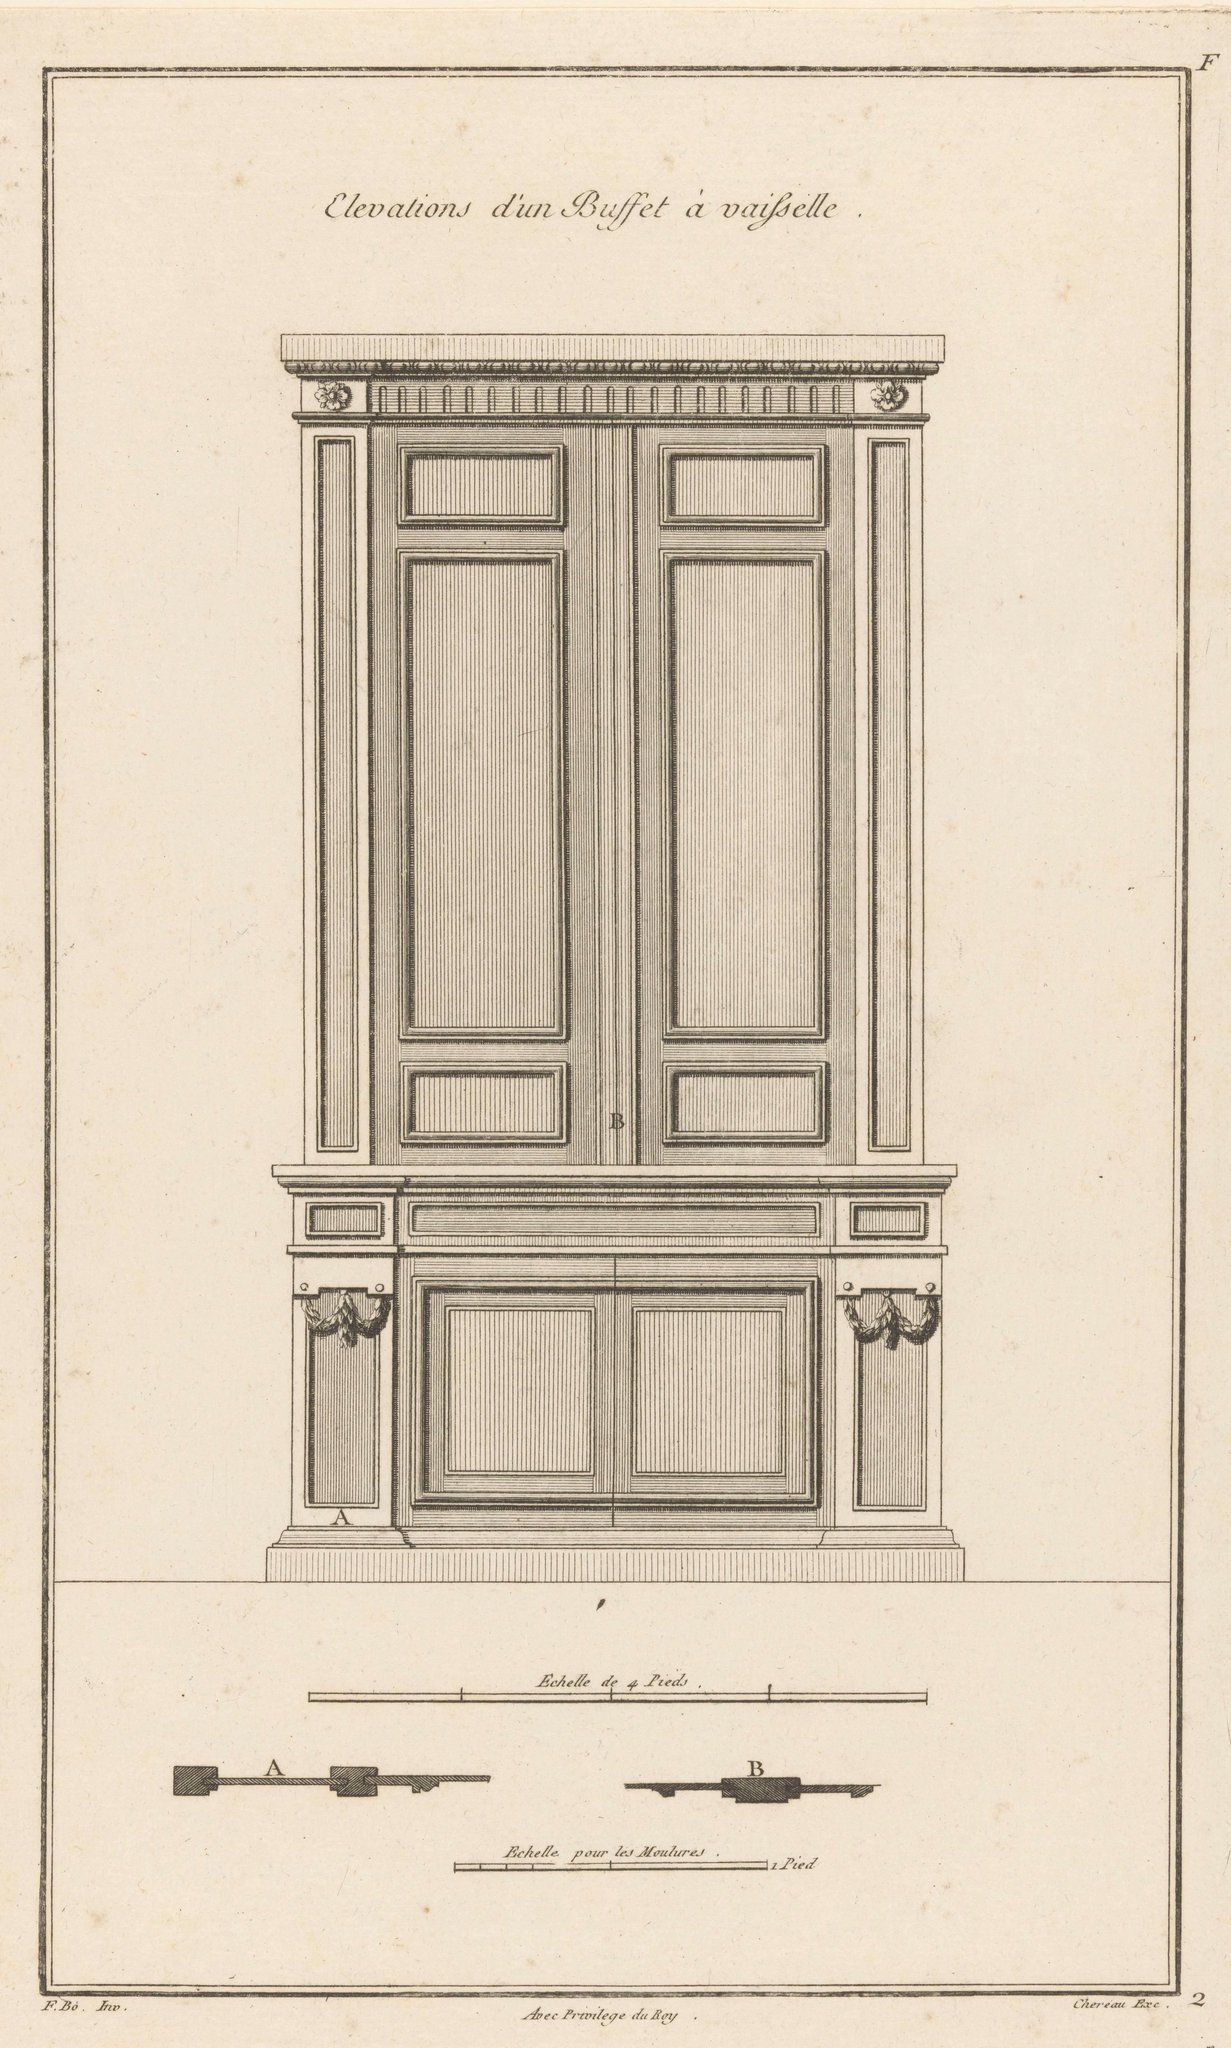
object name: print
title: Elevations d'une Buffet à vaisselle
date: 1752-1794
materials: paper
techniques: engraving, etching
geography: paris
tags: ornamental cupboard, ornament ~ festoon, garland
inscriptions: collector's mark: Lugt 2228, collector's mark: Lugt 2760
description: Ontwerp en profiel van een hoge buffetkast met guirlandes.